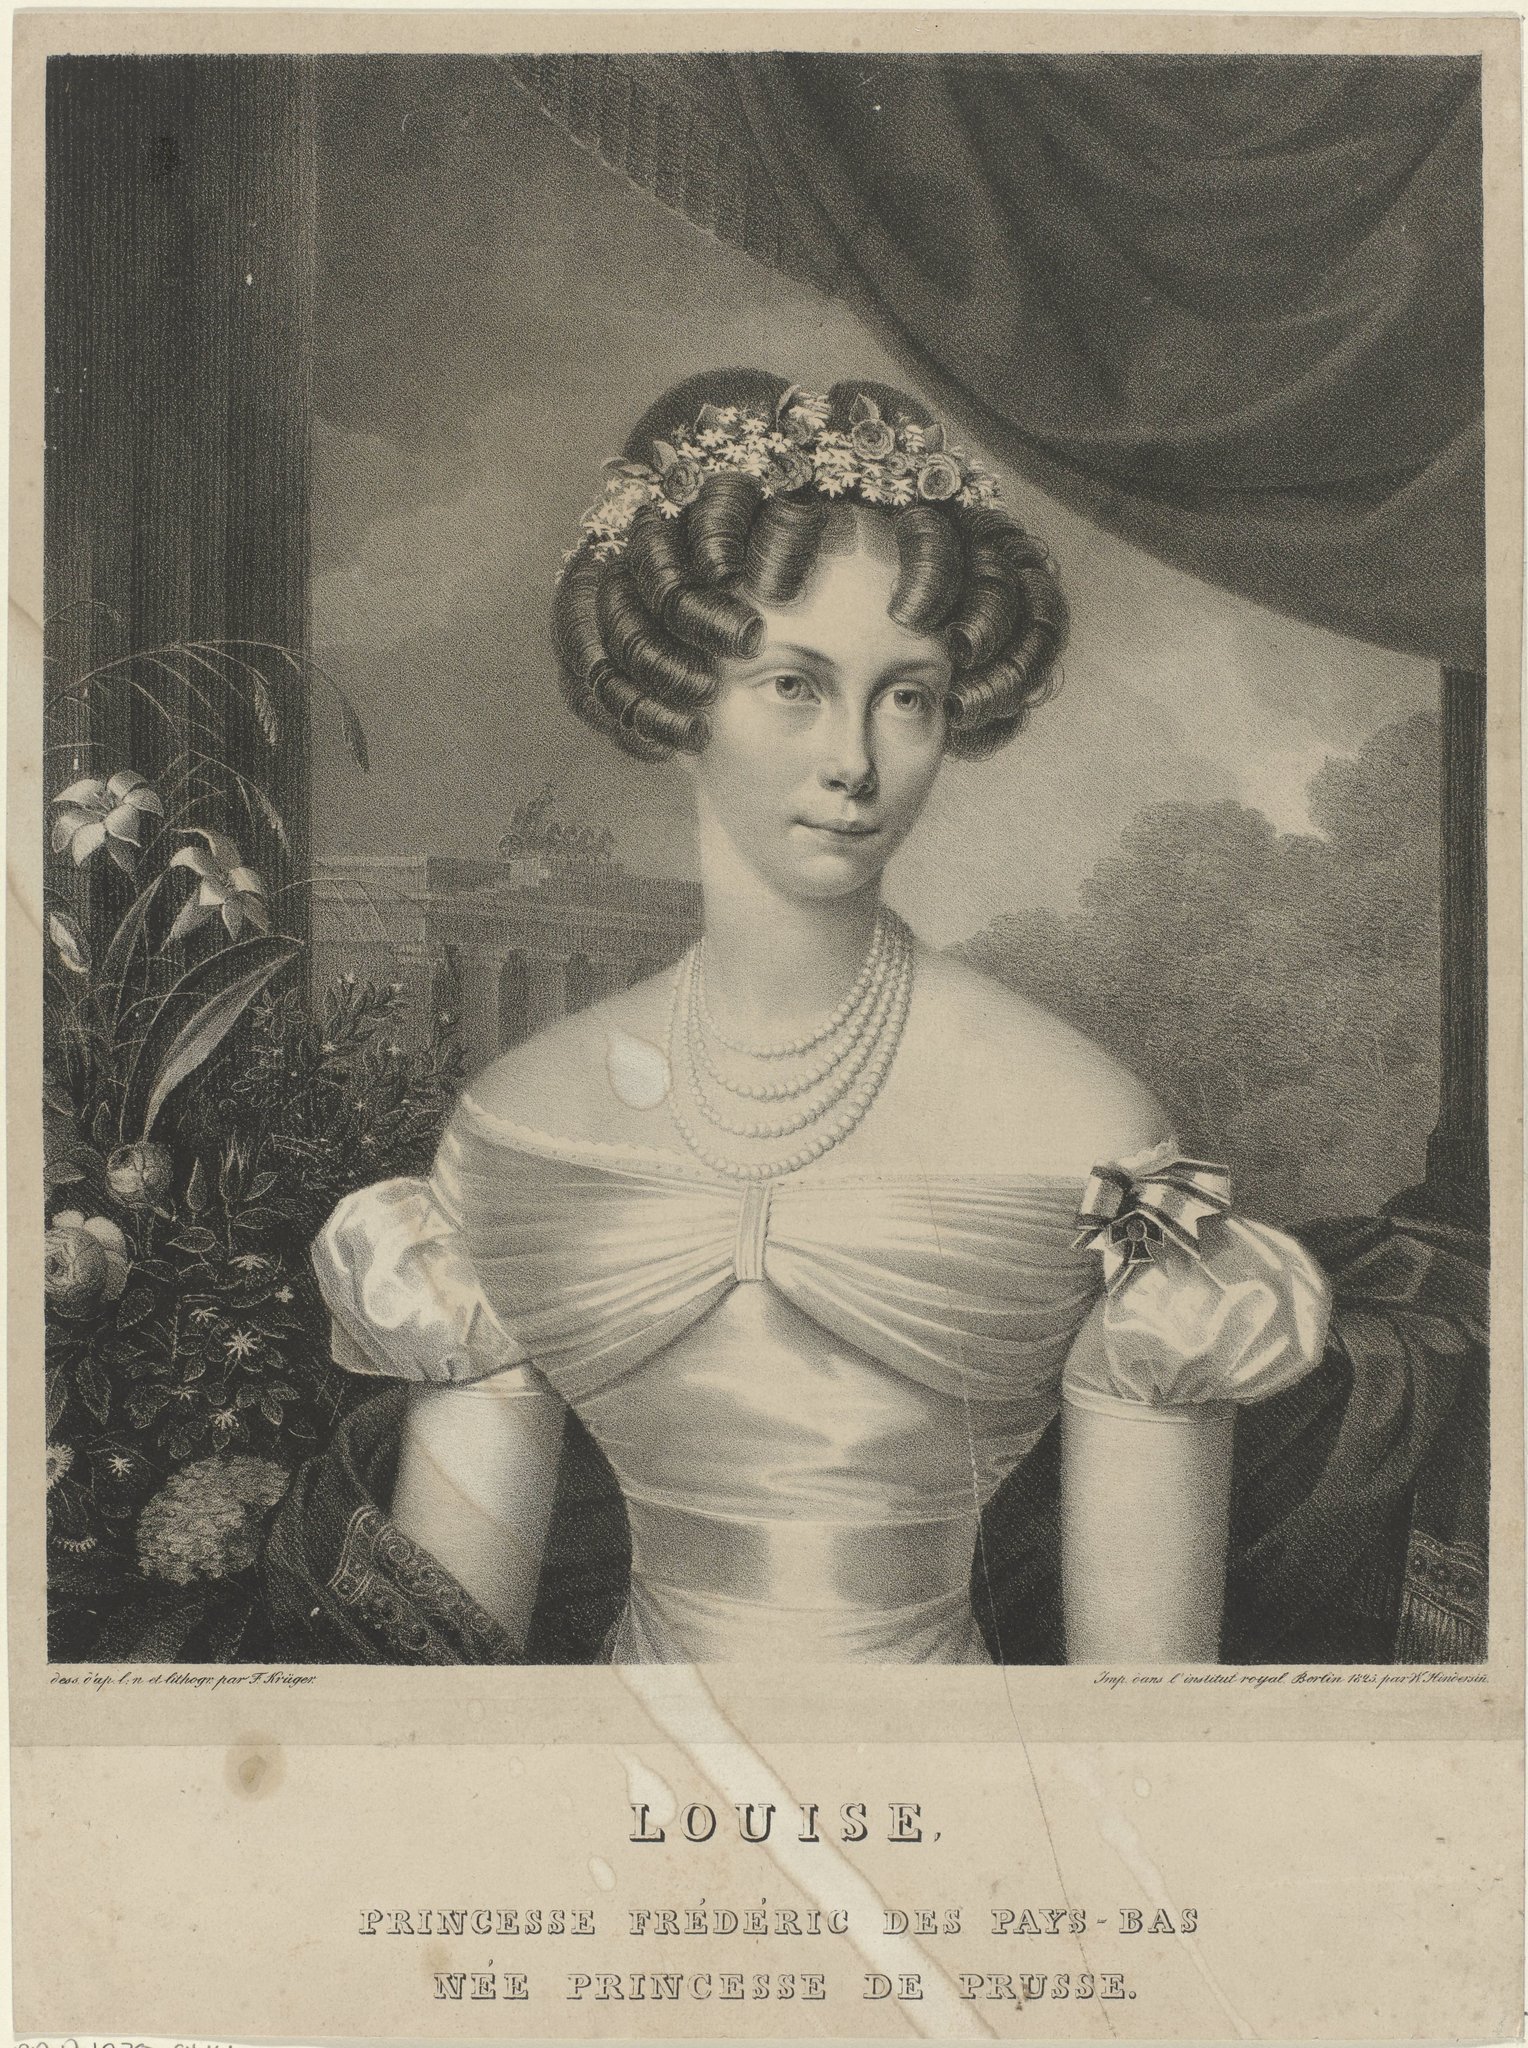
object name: print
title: Portret van Louise van Pruisen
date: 1825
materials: paper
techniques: lithograph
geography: berlin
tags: koningsbergen, wassenaar, prinses, louise van pruisen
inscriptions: collector's mark: Lugt 2228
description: Portret van Louise. Op de achtergrond een doorkijkje. In de ondermarge haar naam en titels.